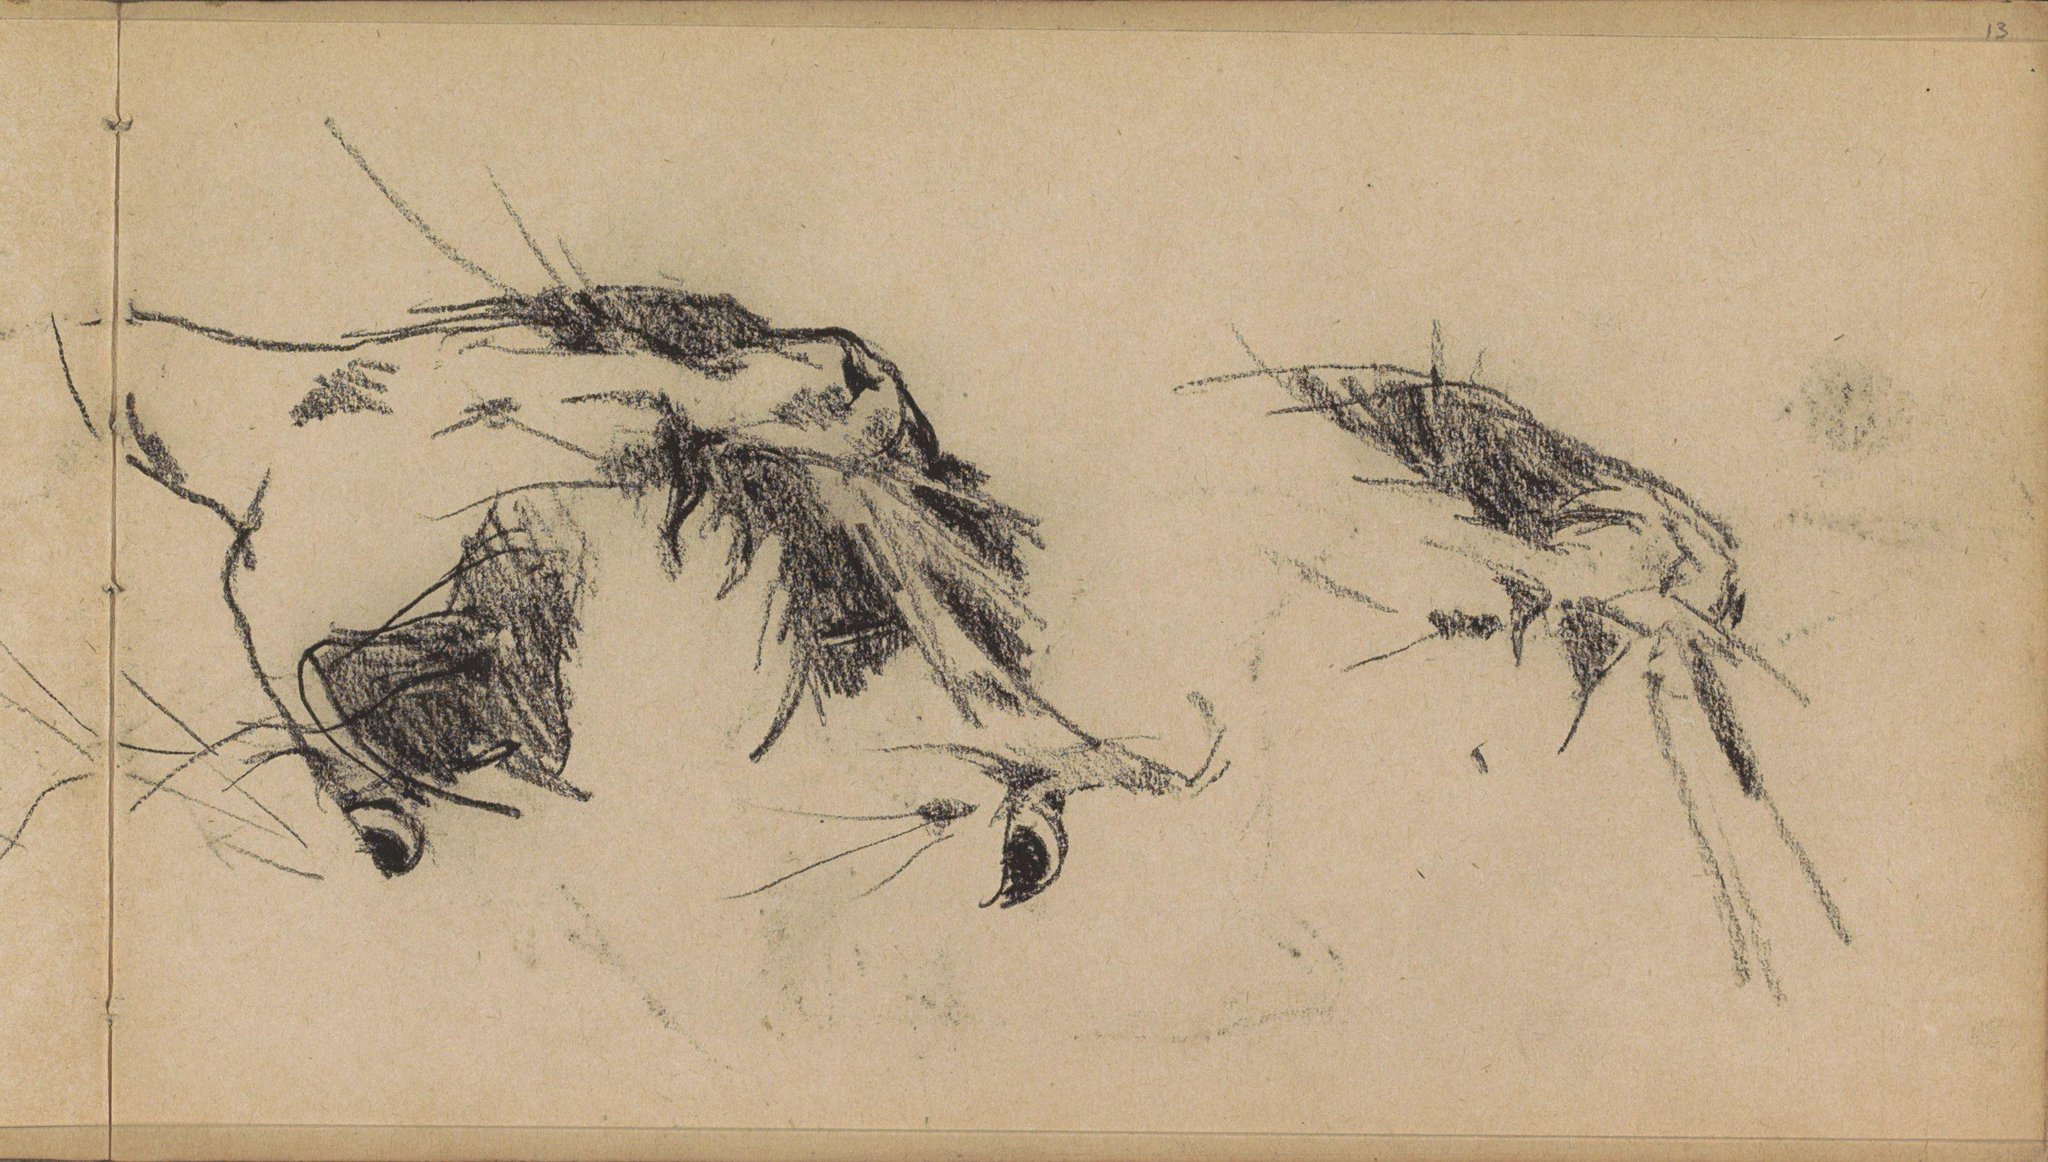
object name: sketchbook leaf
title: Studies van de poes Lola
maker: willem witsen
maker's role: draughtsman, painter, print maker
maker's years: 1860-1923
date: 1887-1888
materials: chalk, paper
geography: amsterdam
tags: cat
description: Voorstudies voor de ets 'Poes Lola', ca. 1887-1888.